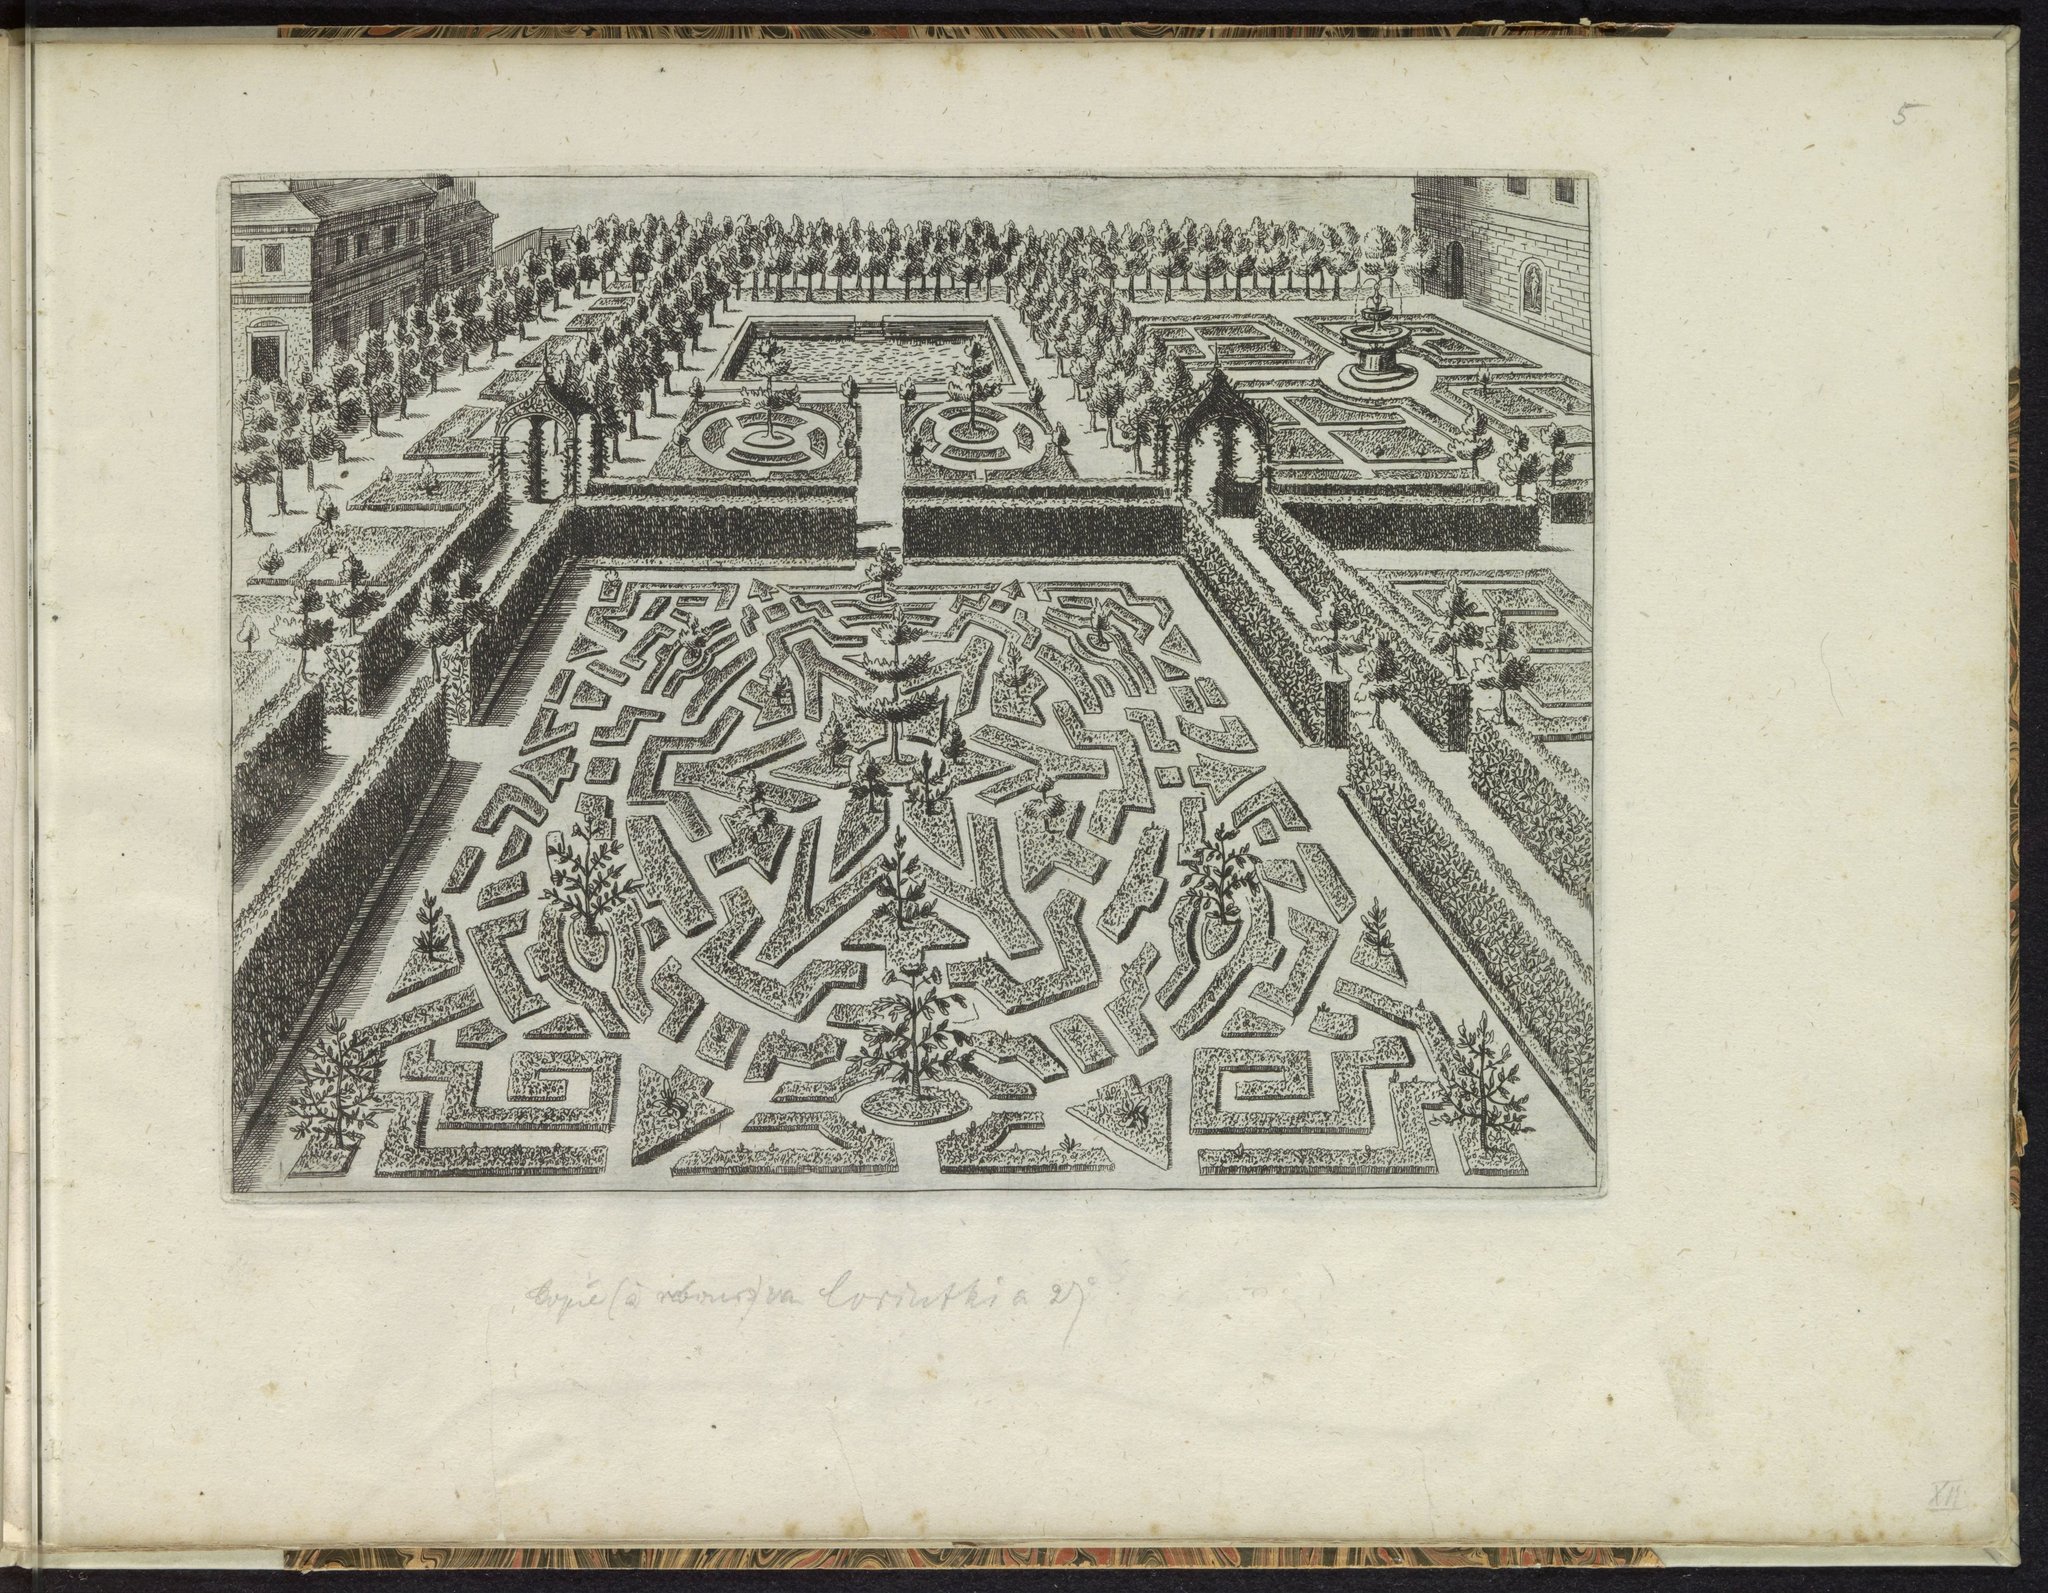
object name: album leaf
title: Hortorum Viridariorumque elegantes et multiplicis formae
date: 1615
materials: paper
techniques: etching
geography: cologne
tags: garden, french or architectonic garden; formal garden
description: Tuin met een parterre met in het centrum een stervormig compartiment. De tuin is aangelegd volgens de Korinthische bouworde. De prent maakt deel uit van een album.